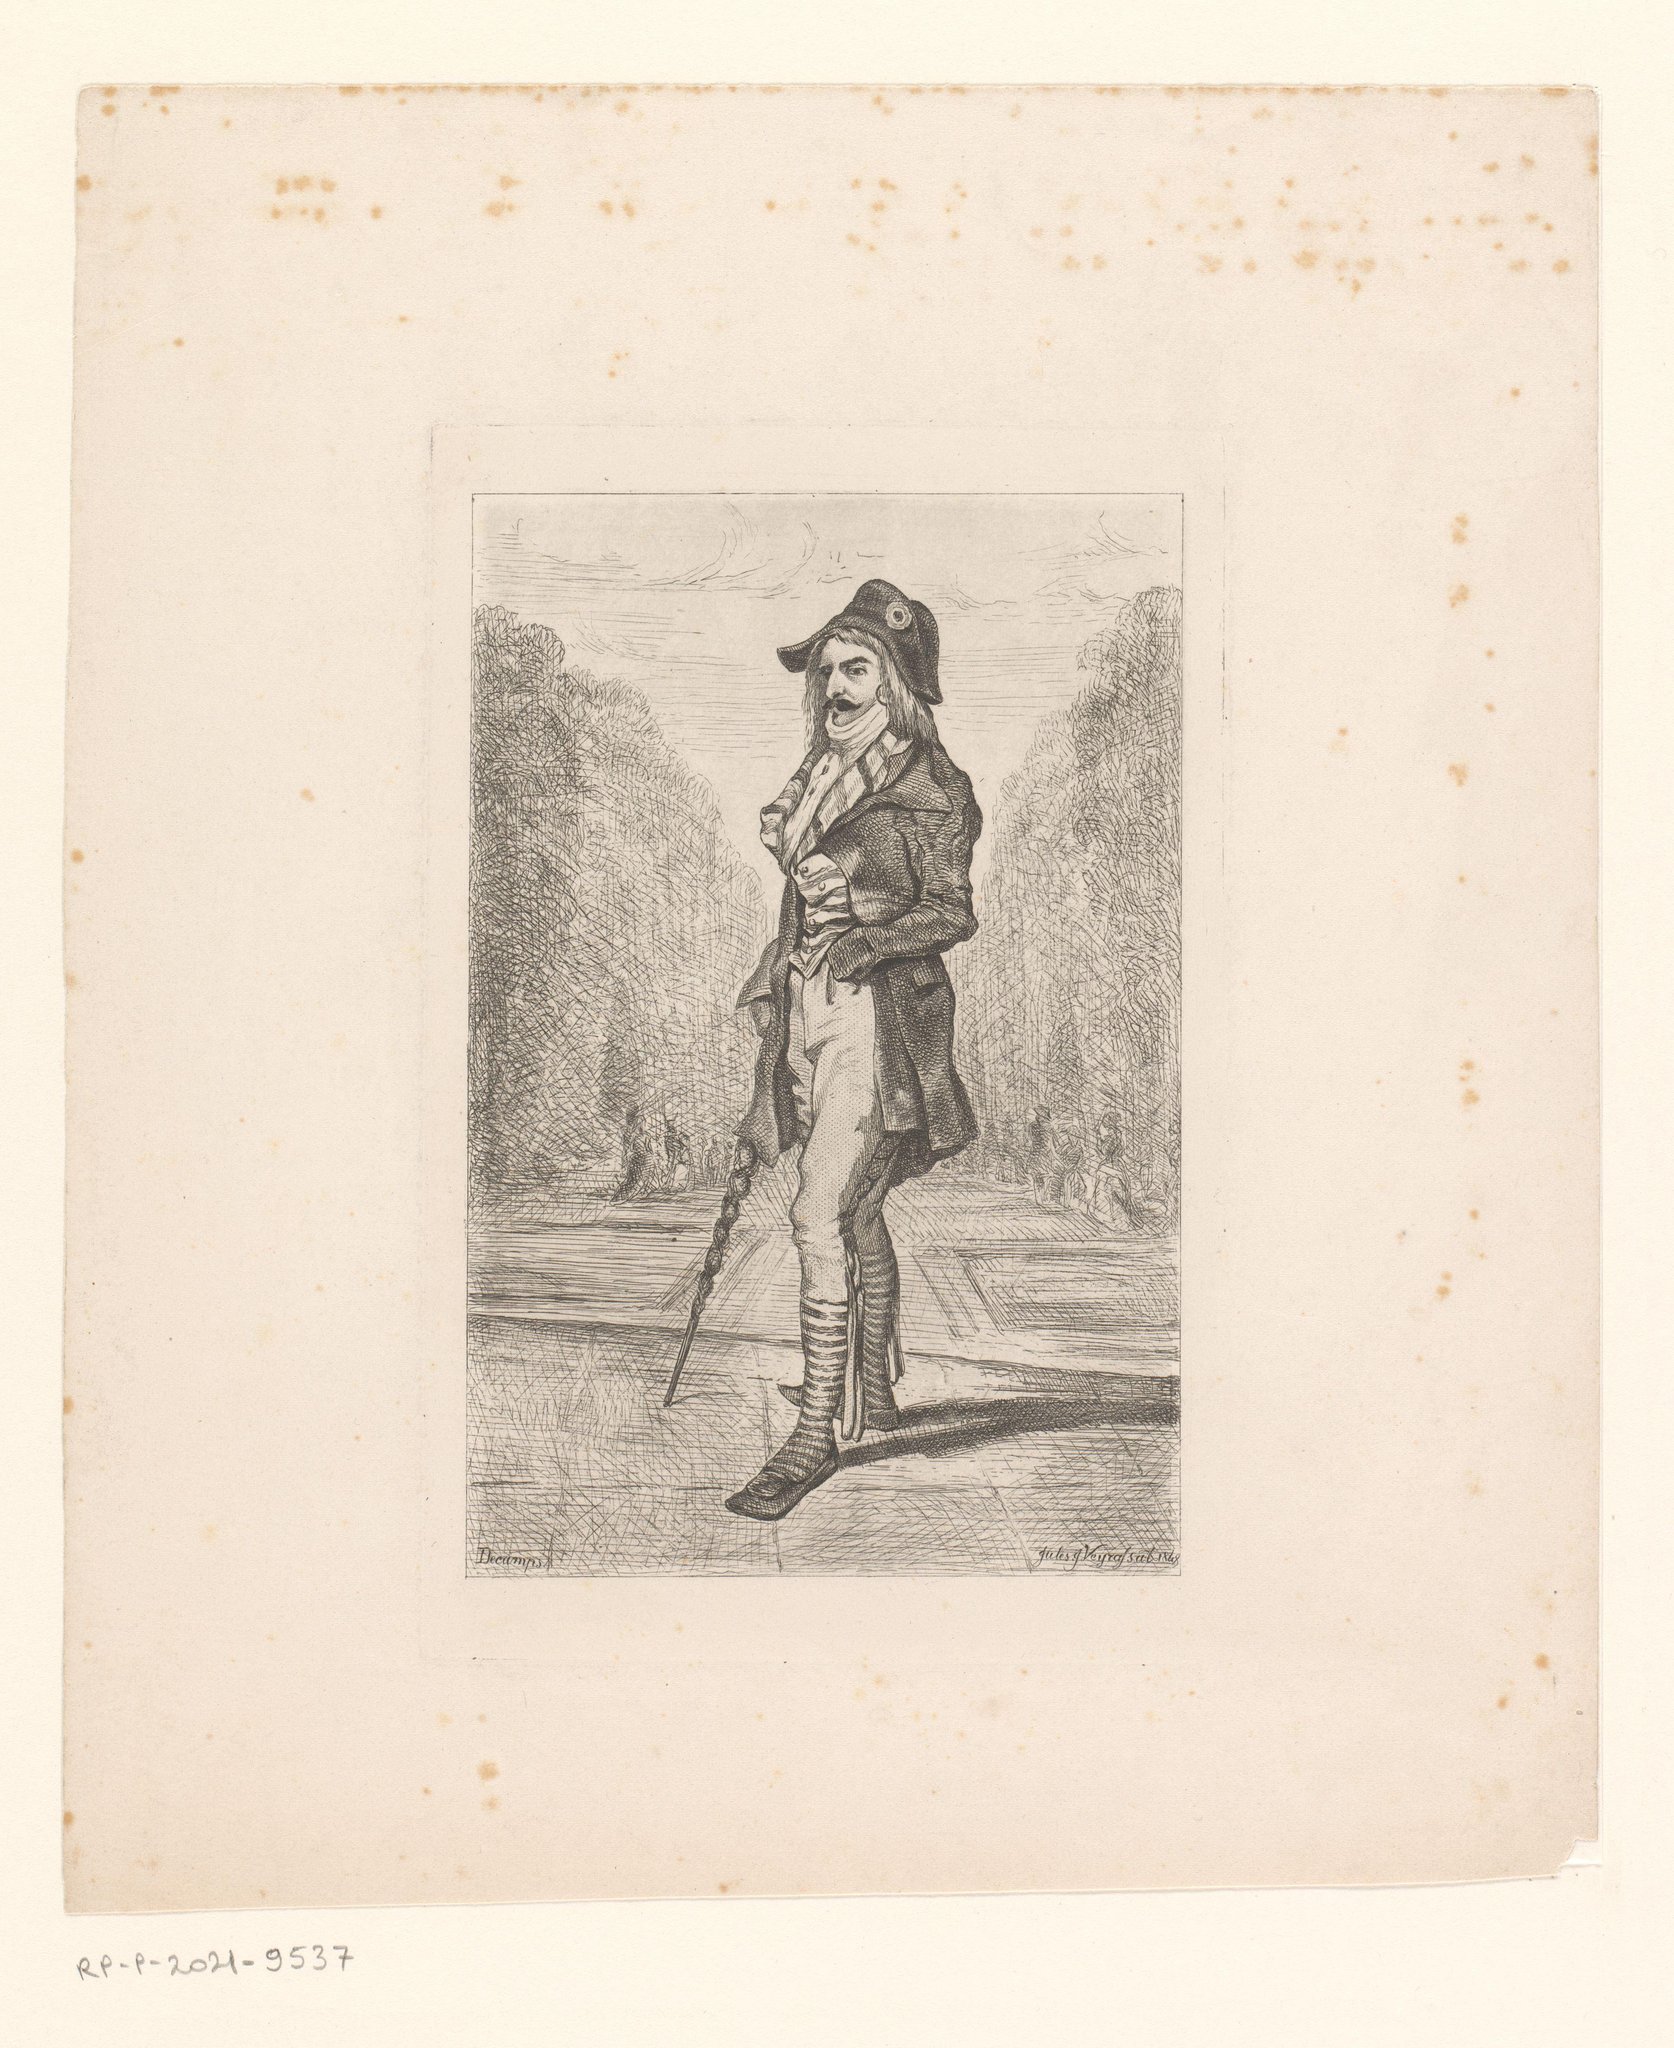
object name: print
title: Man met tweekantige steek, oorring en wandelstok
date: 1848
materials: paper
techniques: etching, intaglio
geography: france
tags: head-gear: bicorne, bicorn, moustache, fan, ear-rings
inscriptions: date